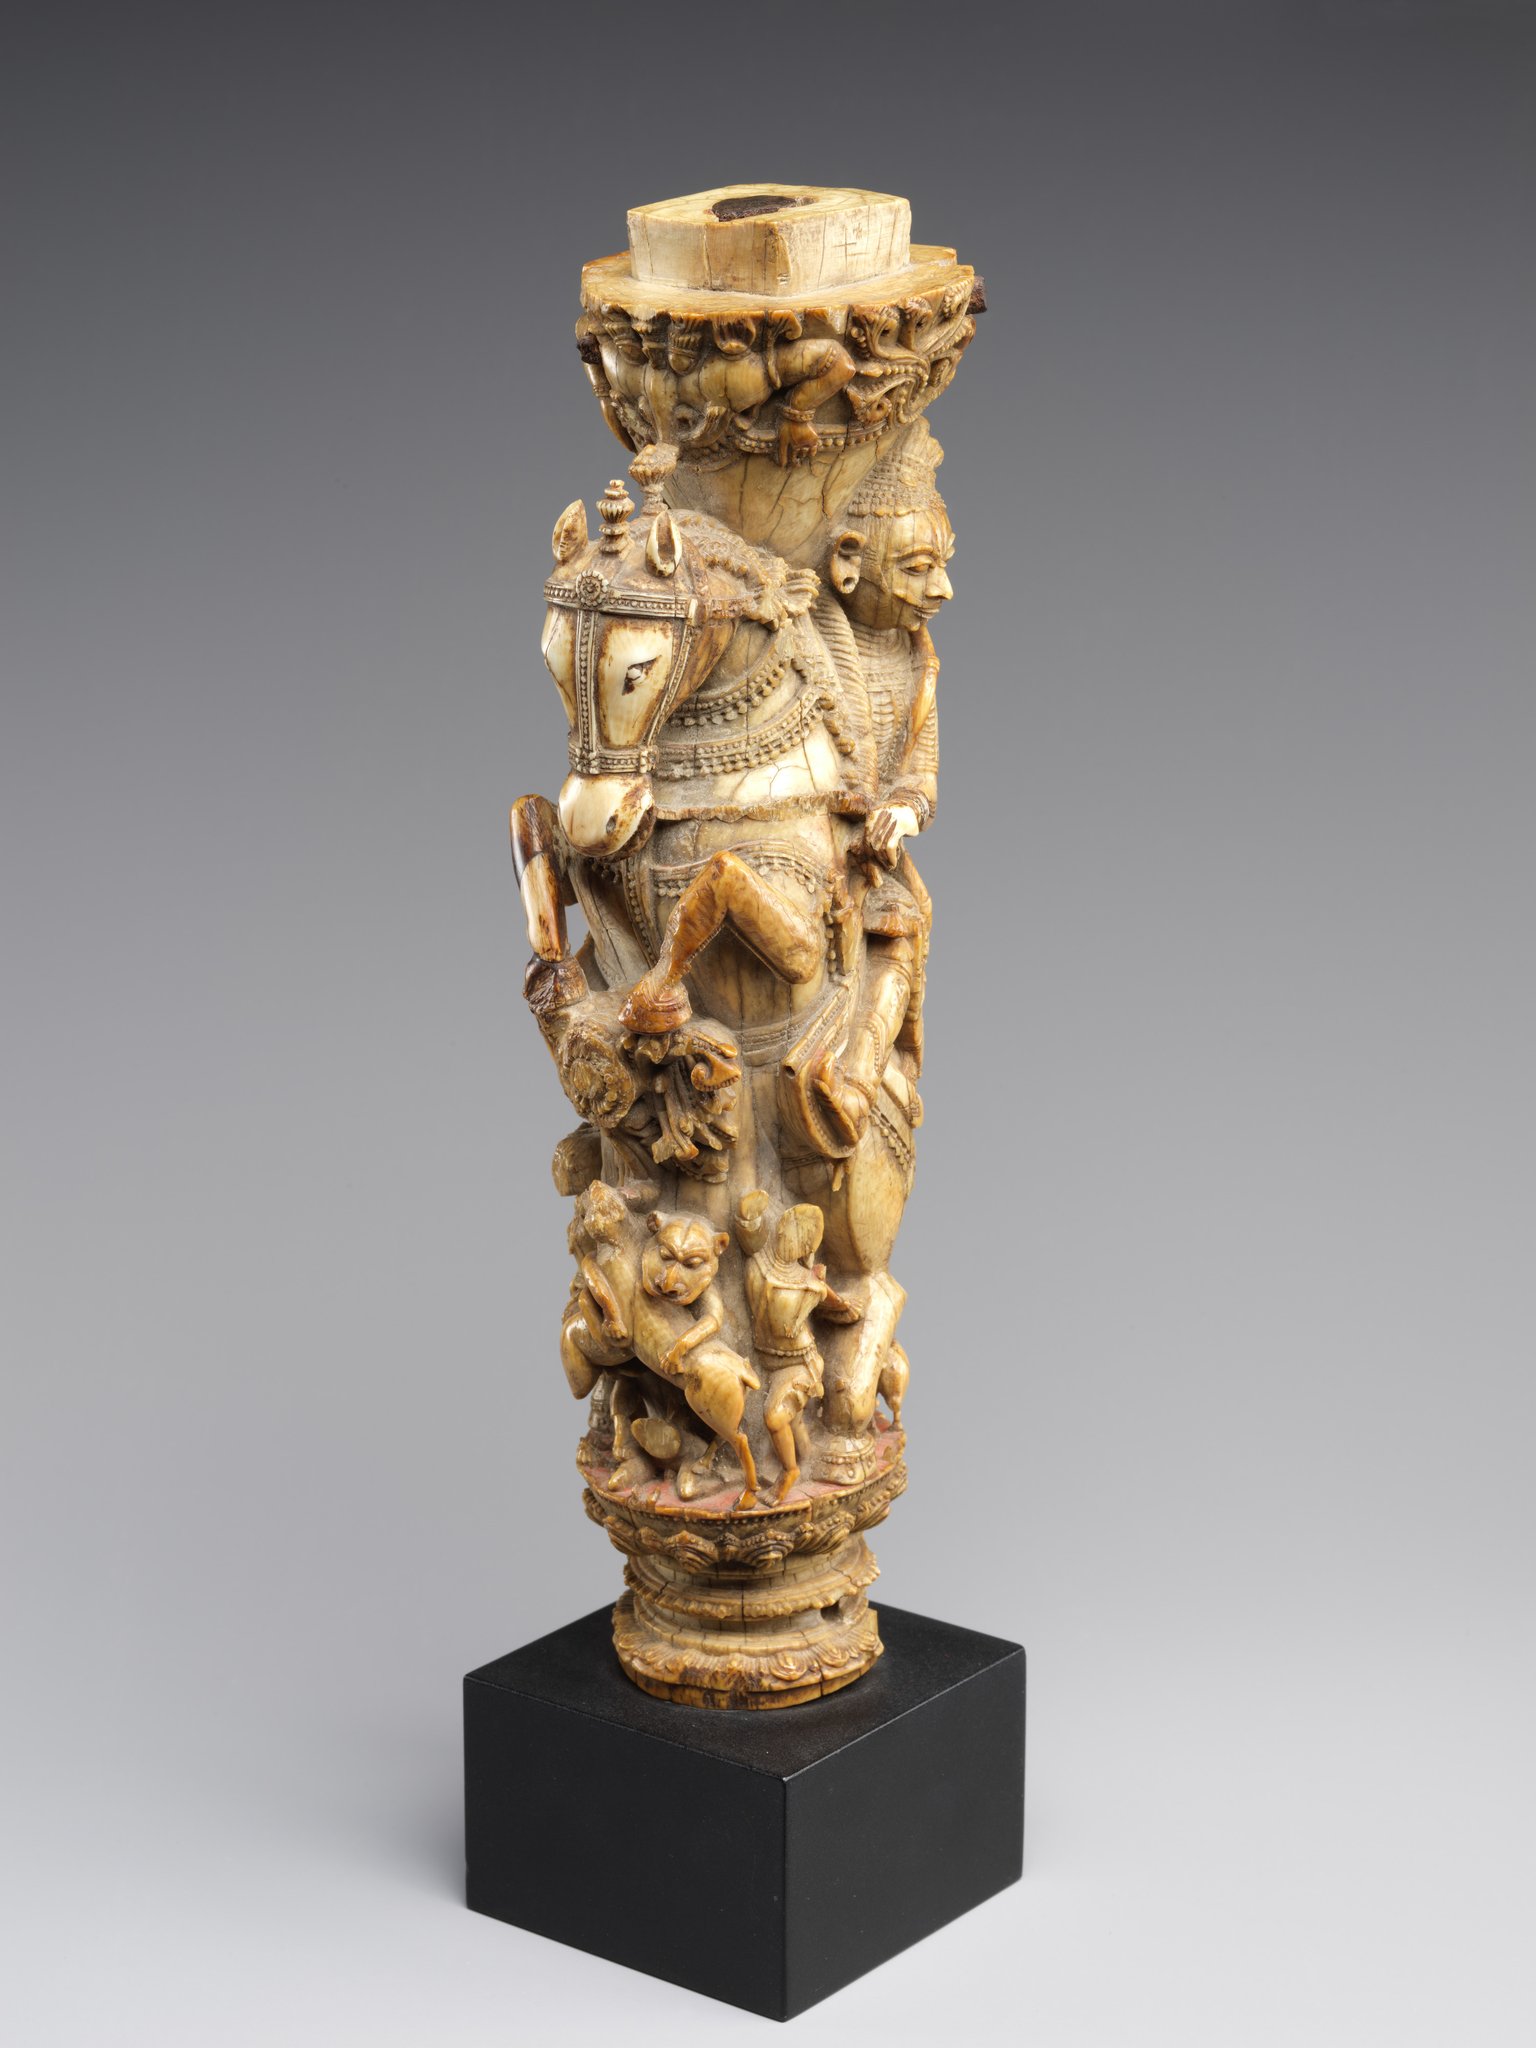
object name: throne leg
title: Royal throne leg with equestrian warrior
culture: eastern indian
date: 1601-1700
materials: iron, ivory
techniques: polychrome